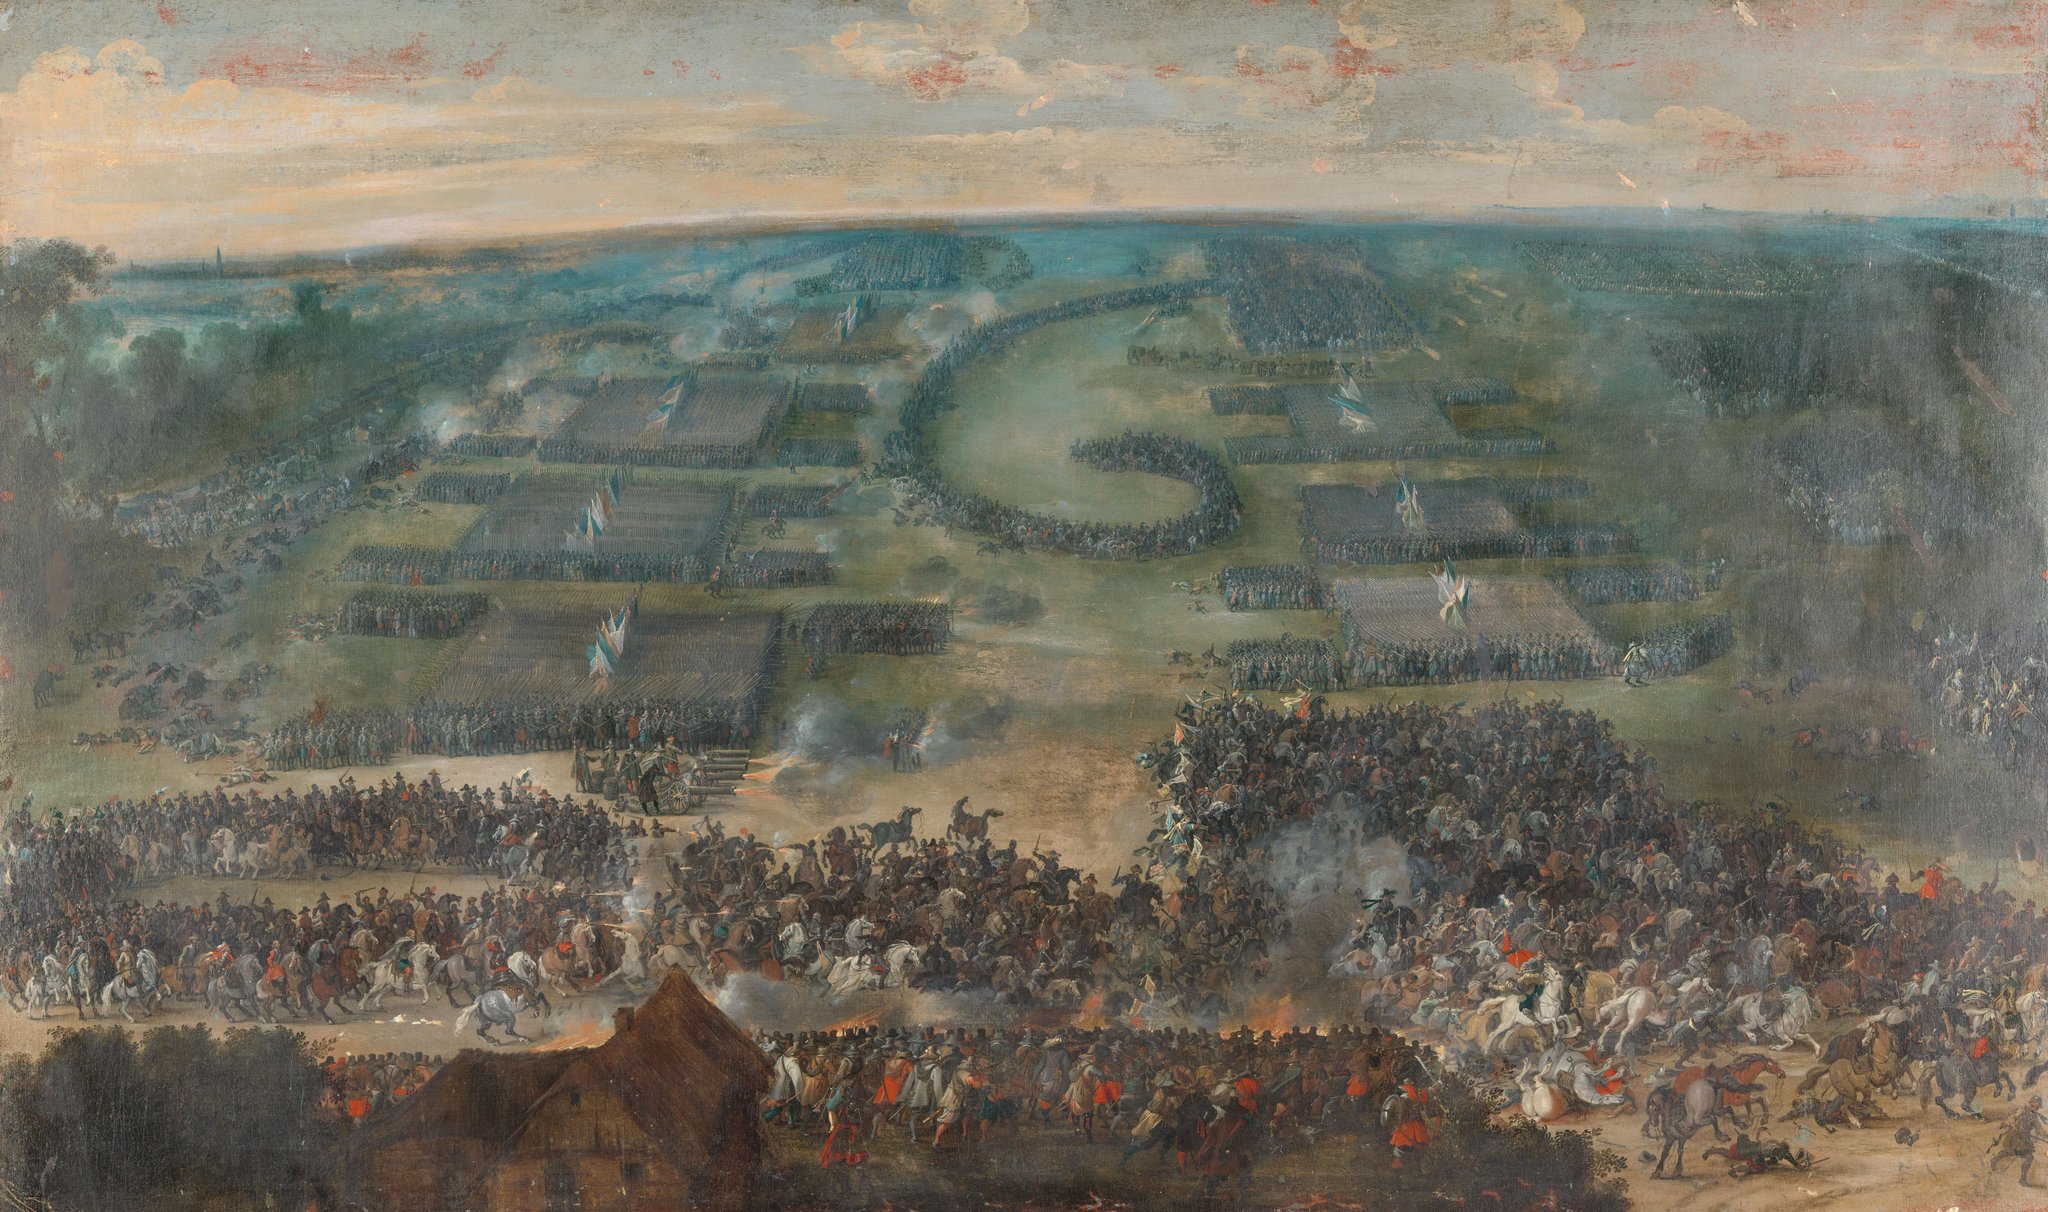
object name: painting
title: The Battle of Fleurus, 1622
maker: peeter snayers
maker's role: draughtsman, painter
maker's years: 1592-1666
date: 1630-1640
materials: canvas, oil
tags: battle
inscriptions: inscription, double capital letters identifying a troop formation, in the middle ground: ‘AA’, inscription, double capital letters identifying a troop formation, in the far right from the top down: ‘BB’, inscription, indecipherable text, upper left, in the sky above the spire, inscription, single capital letters identifying troop formations, on the left from the top down: ‘A, B, C, D, F’, inscription, double capital letters identifying troop formations, in the right top down: ‘DD, EE, CC, CC, CC’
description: Een grote veldslag gezien in vogelvluchtperspectief. Op de voorgrond een cavaleriegevecht, daarachter artillerie en infanterie. Boven maakt een divisie ruiters een spiraalvormige beweging. Wellicht de slag bij Wimpfen in Duitsland in 1622.